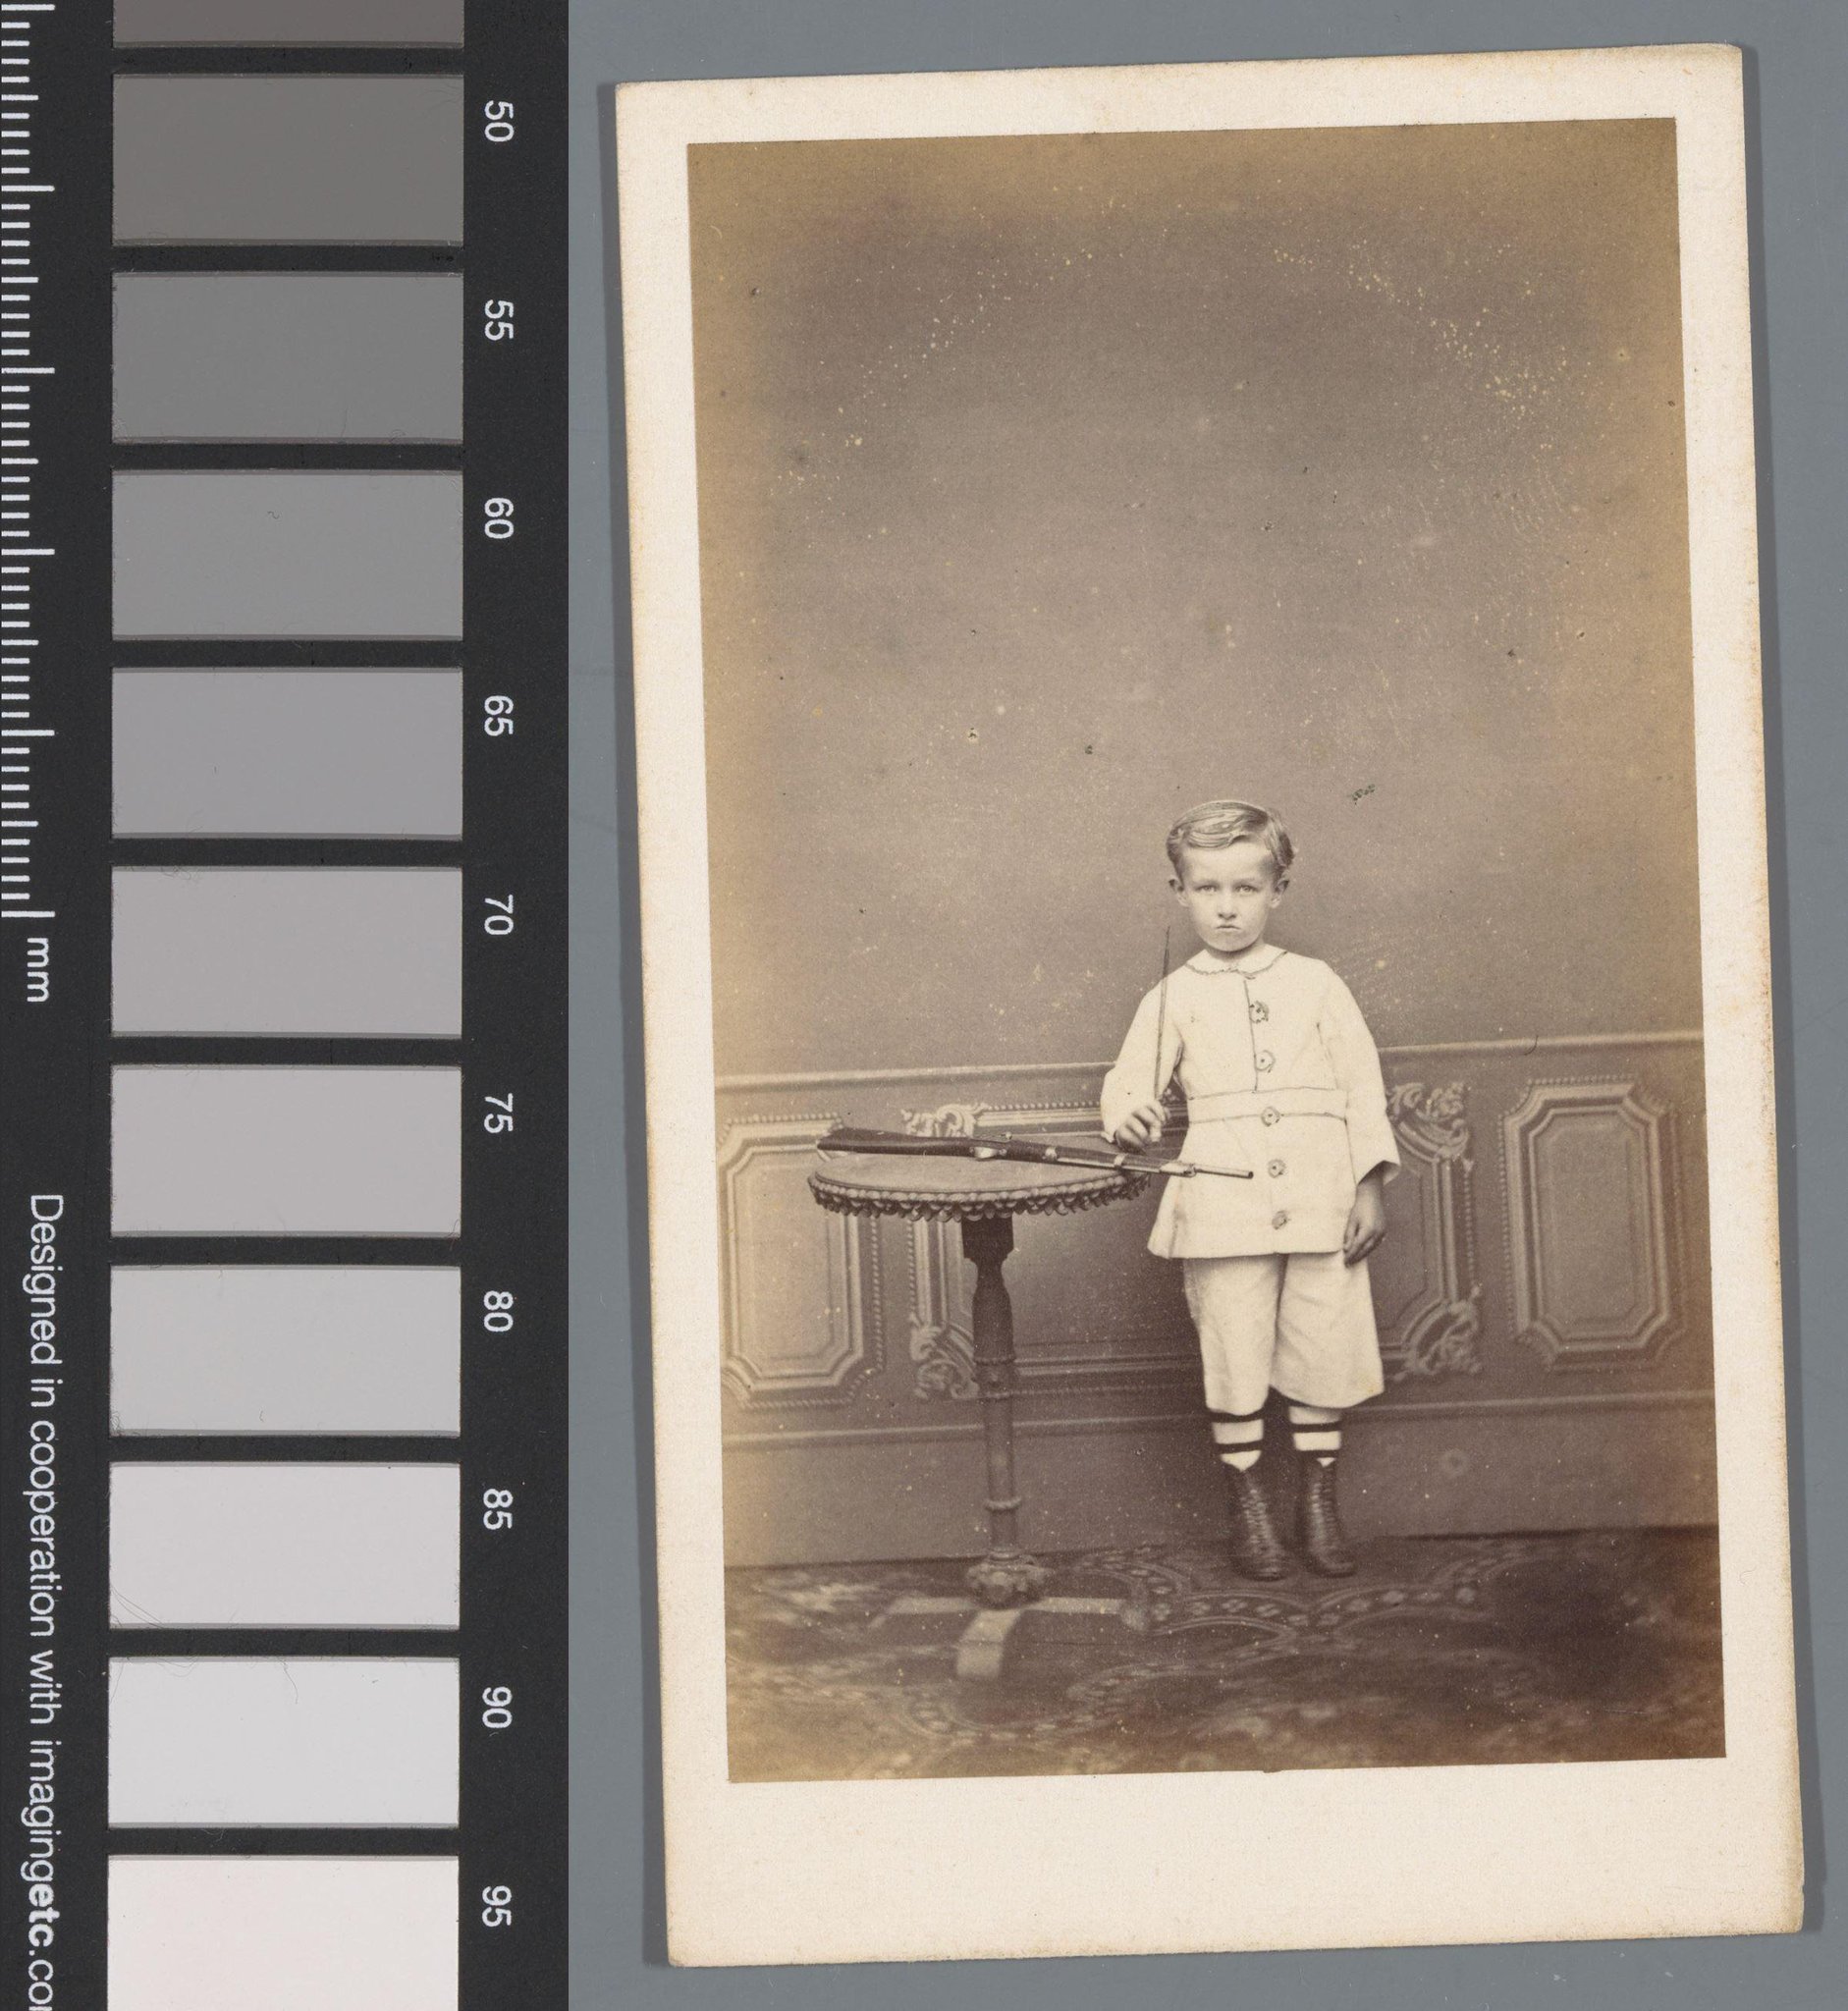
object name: carte de visite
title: Portret van een onbekende jongen naast een geweer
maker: august rombaut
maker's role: fotograaf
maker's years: 1834-1892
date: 1865-1866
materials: cardboard, paper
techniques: albumen print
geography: sint-niklaas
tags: boy (child between toddler and youth), anonymous historical person portrayed, firearms: rifle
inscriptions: address: ‘St NIKOLAAS, NIEUWSTRAAT,/ No 19.’